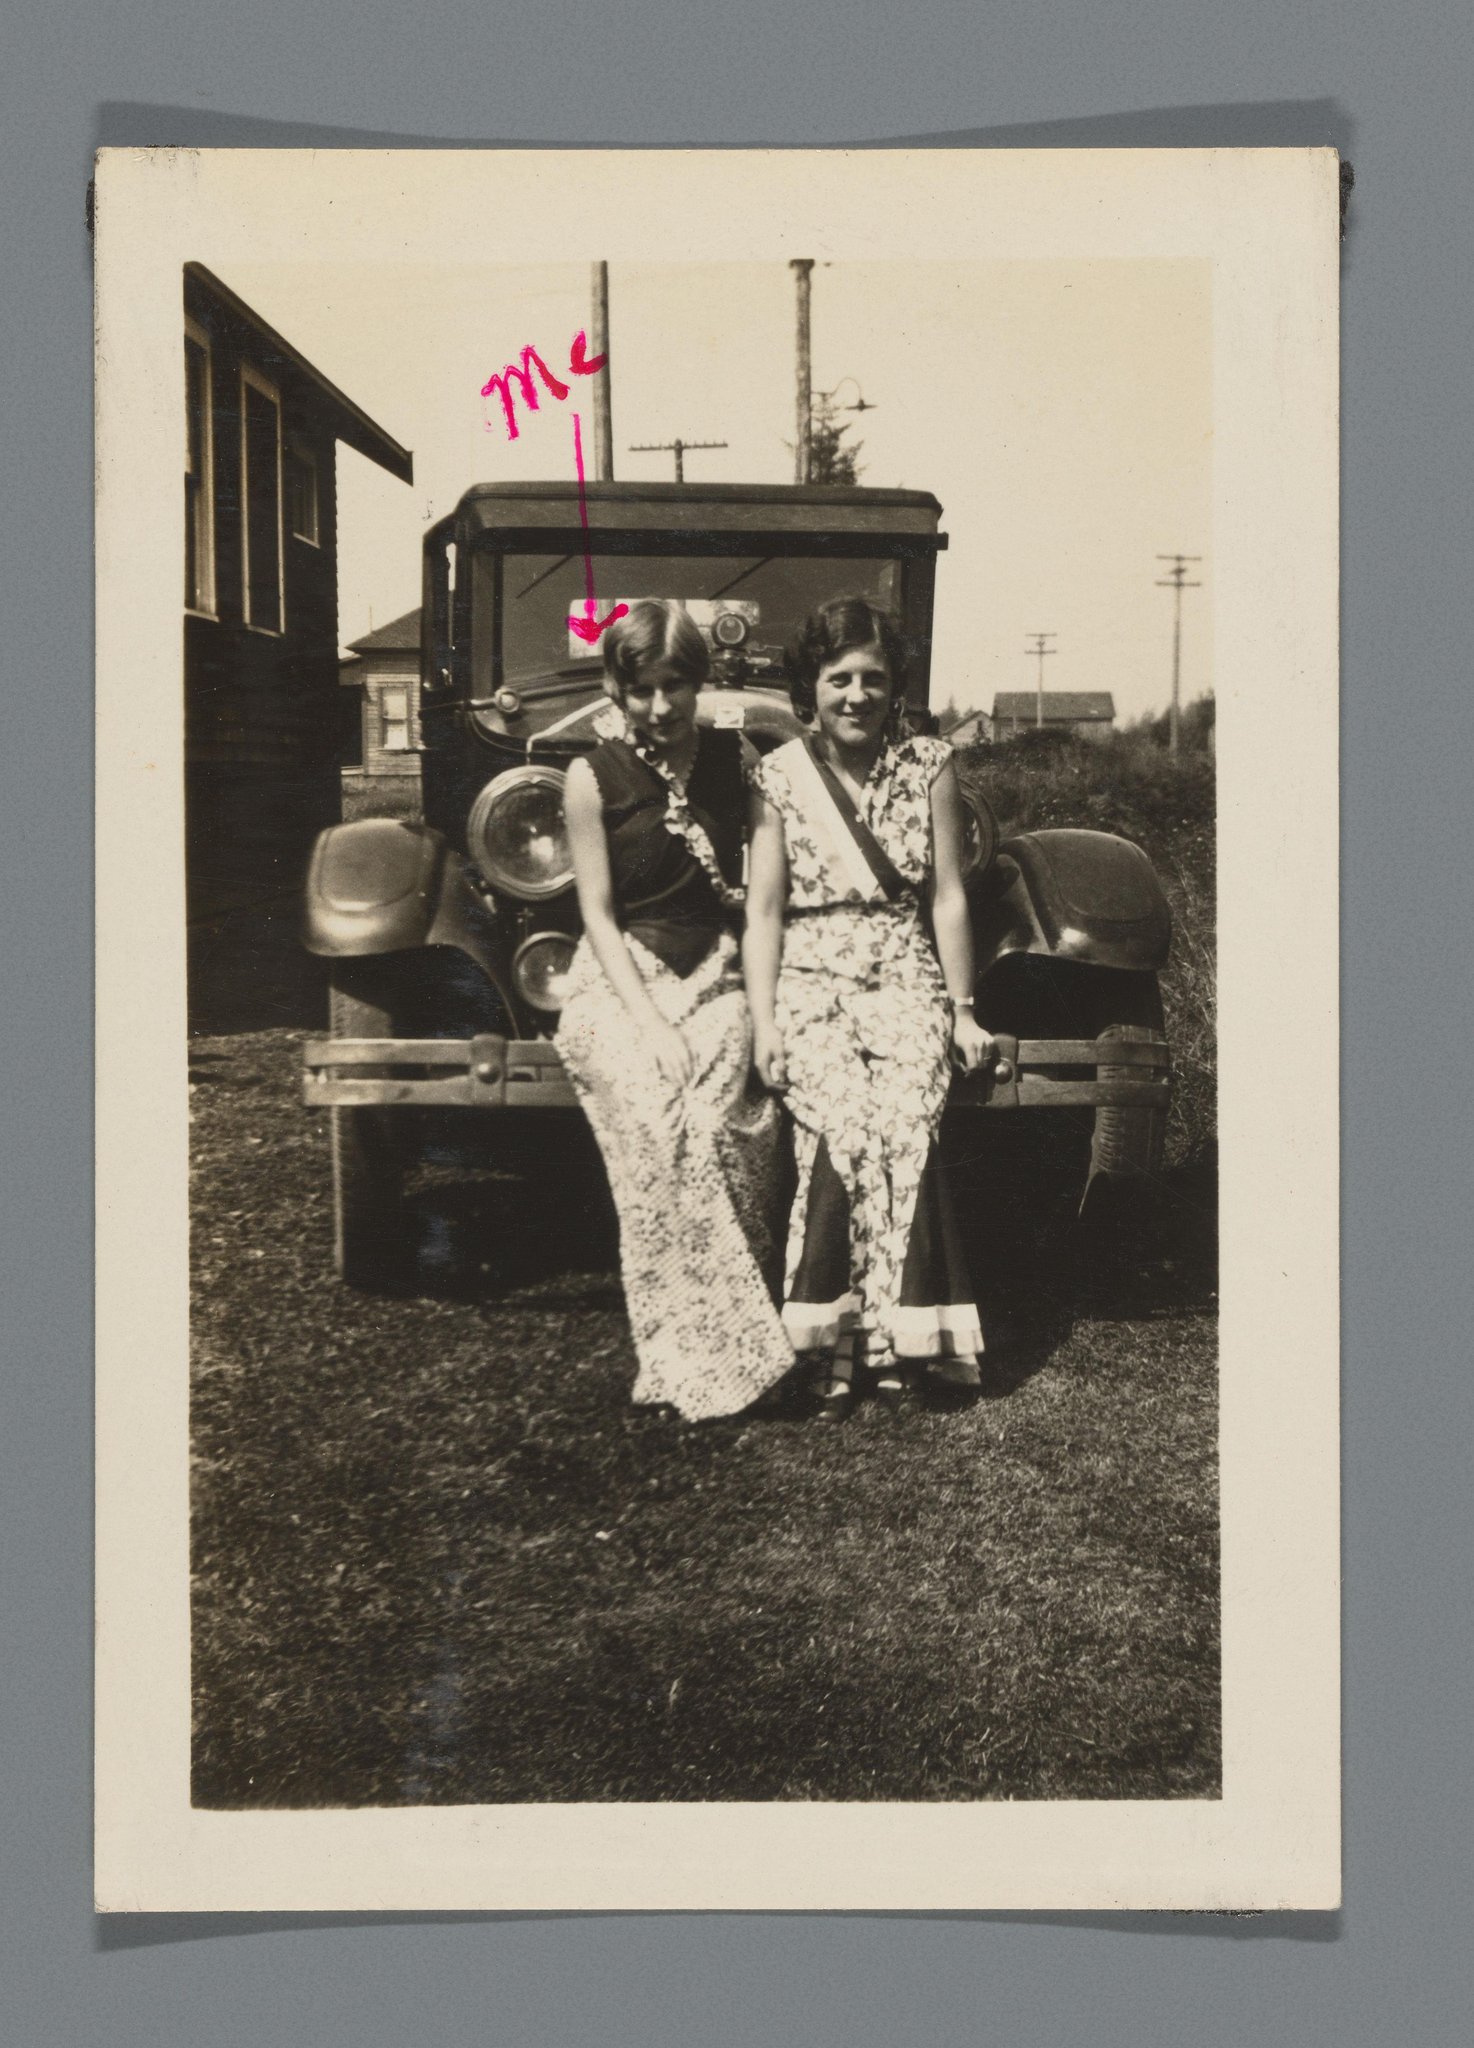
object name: photograph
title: Portret van twee vrouwen zittend op de bumper van een auto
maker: Anonymous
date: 1920-1930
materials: paper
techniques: gelatin silver print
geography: united states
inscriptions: inscription: ‘me’, stamp: ‘27’